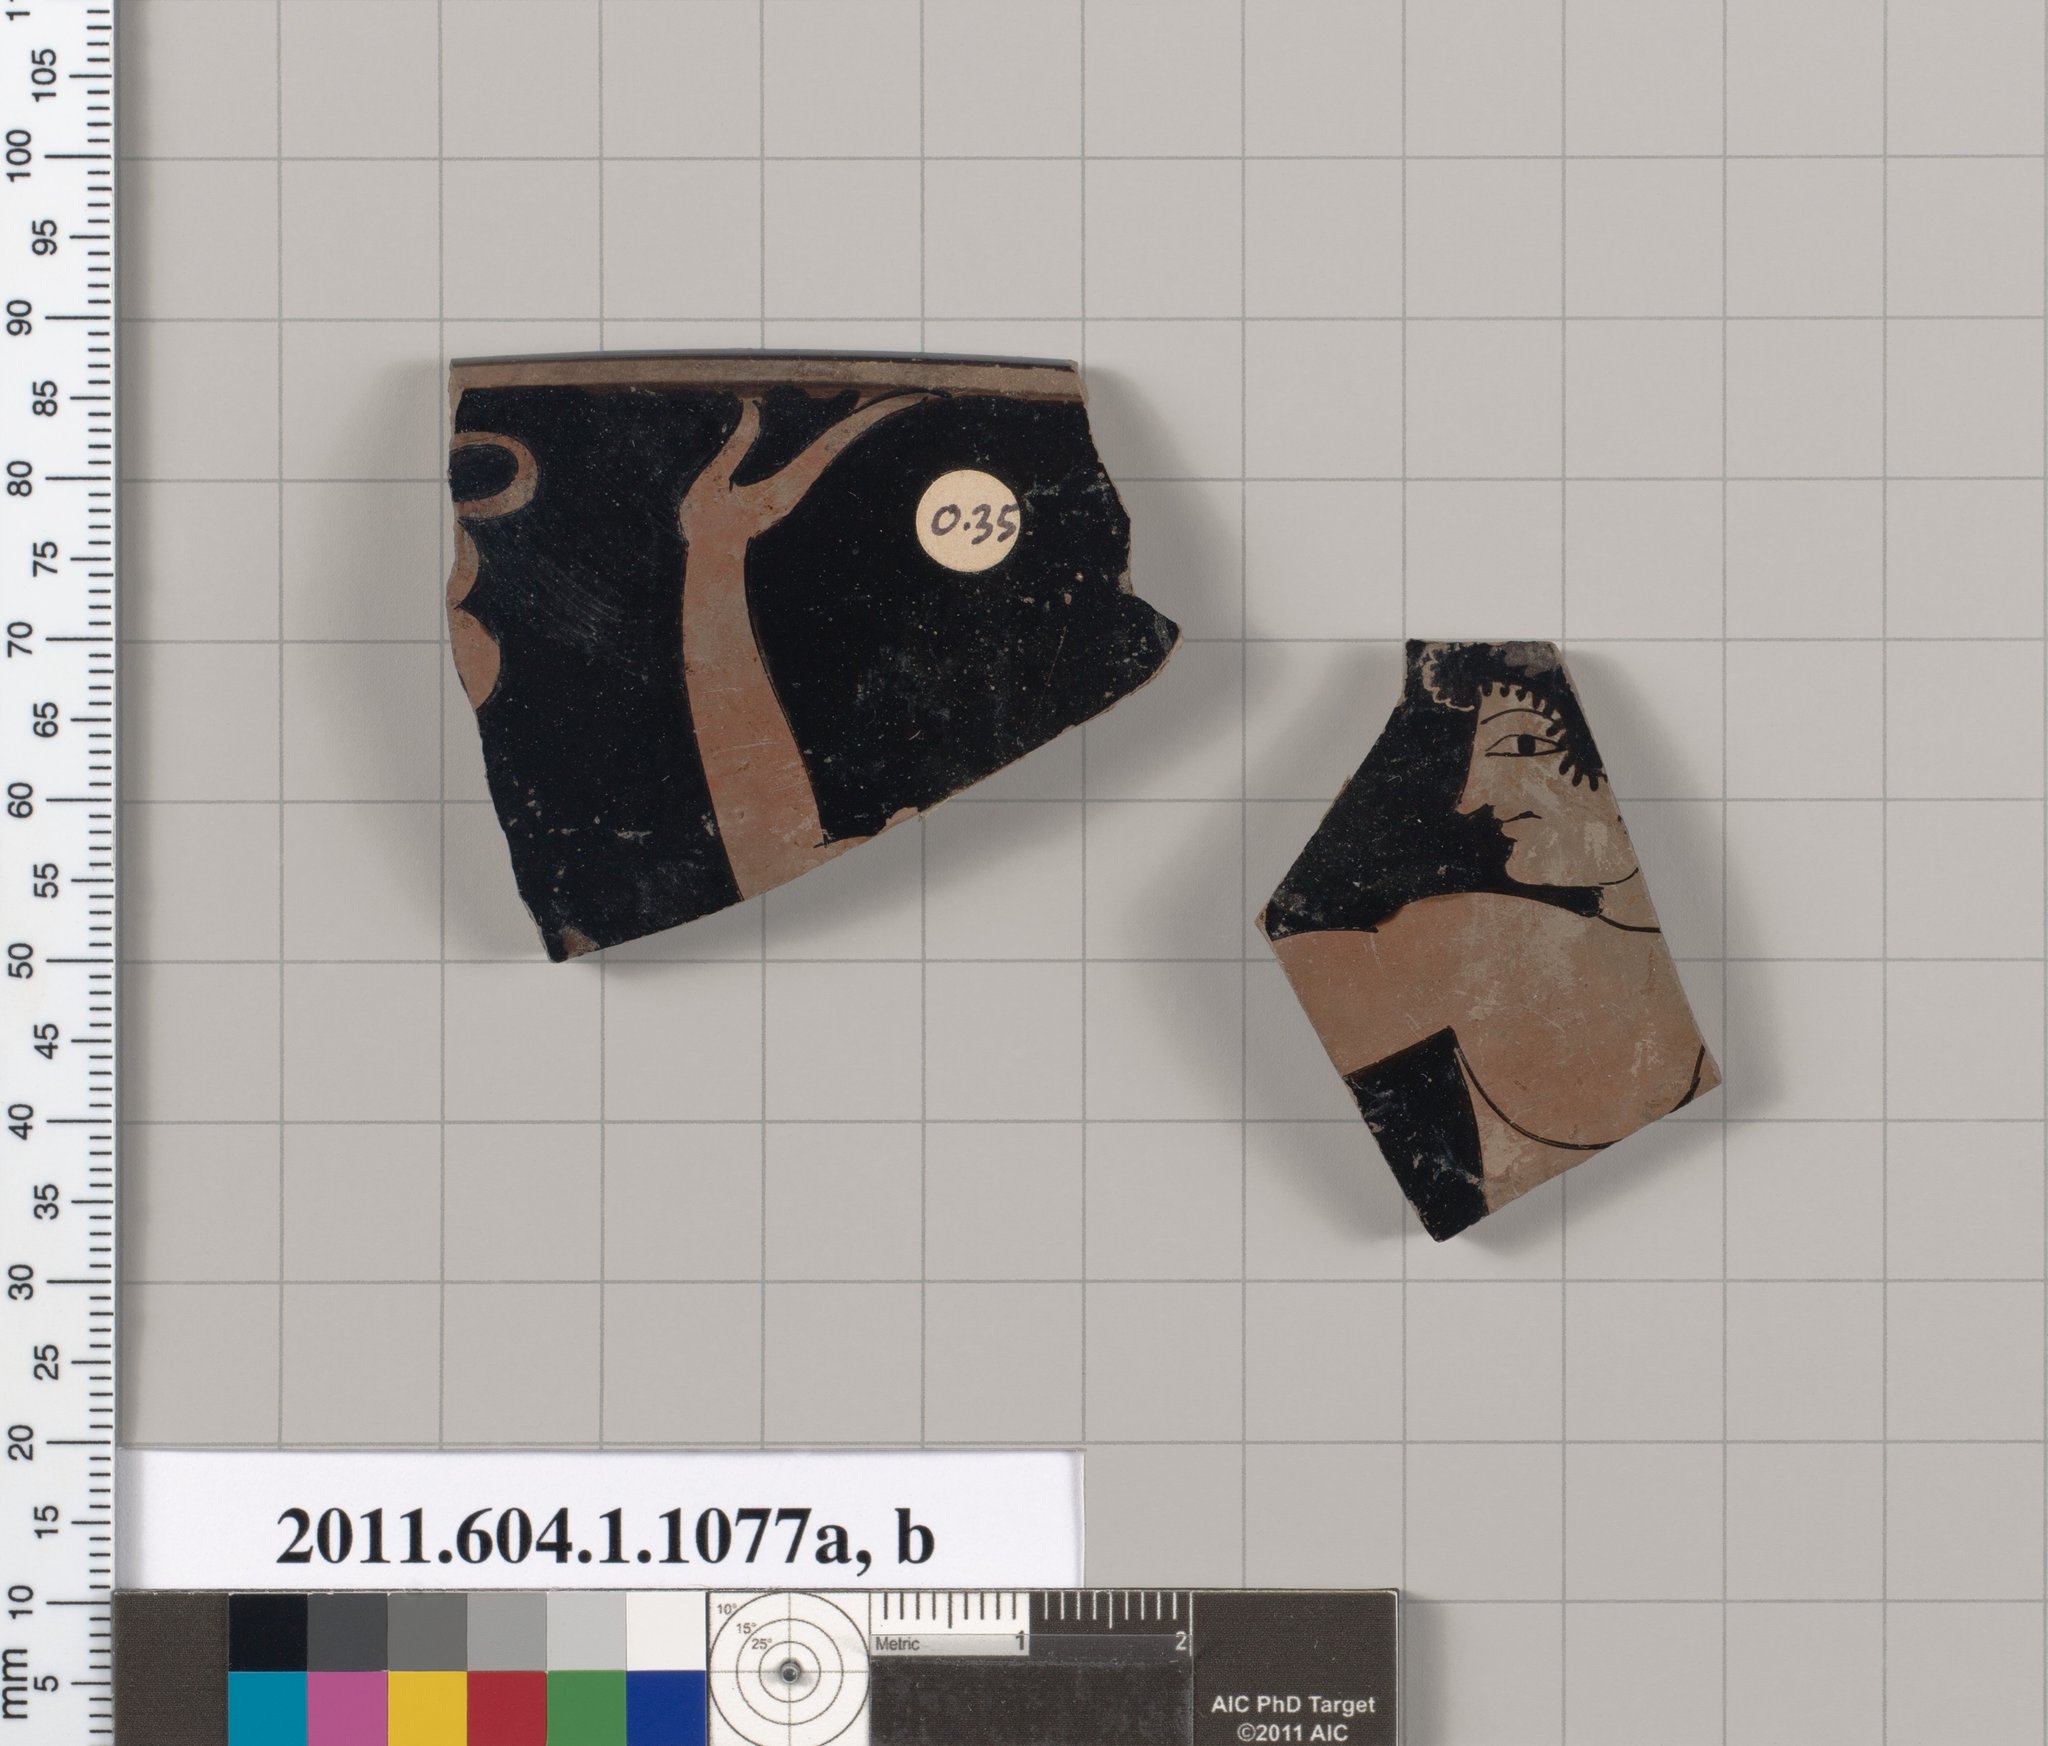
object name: kylix fragment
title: Terracotta rim fragments of a kylix (drinking cup)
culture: greek, attic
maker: poseidon painter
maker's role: artist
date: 510-500 BCE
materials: terracotta